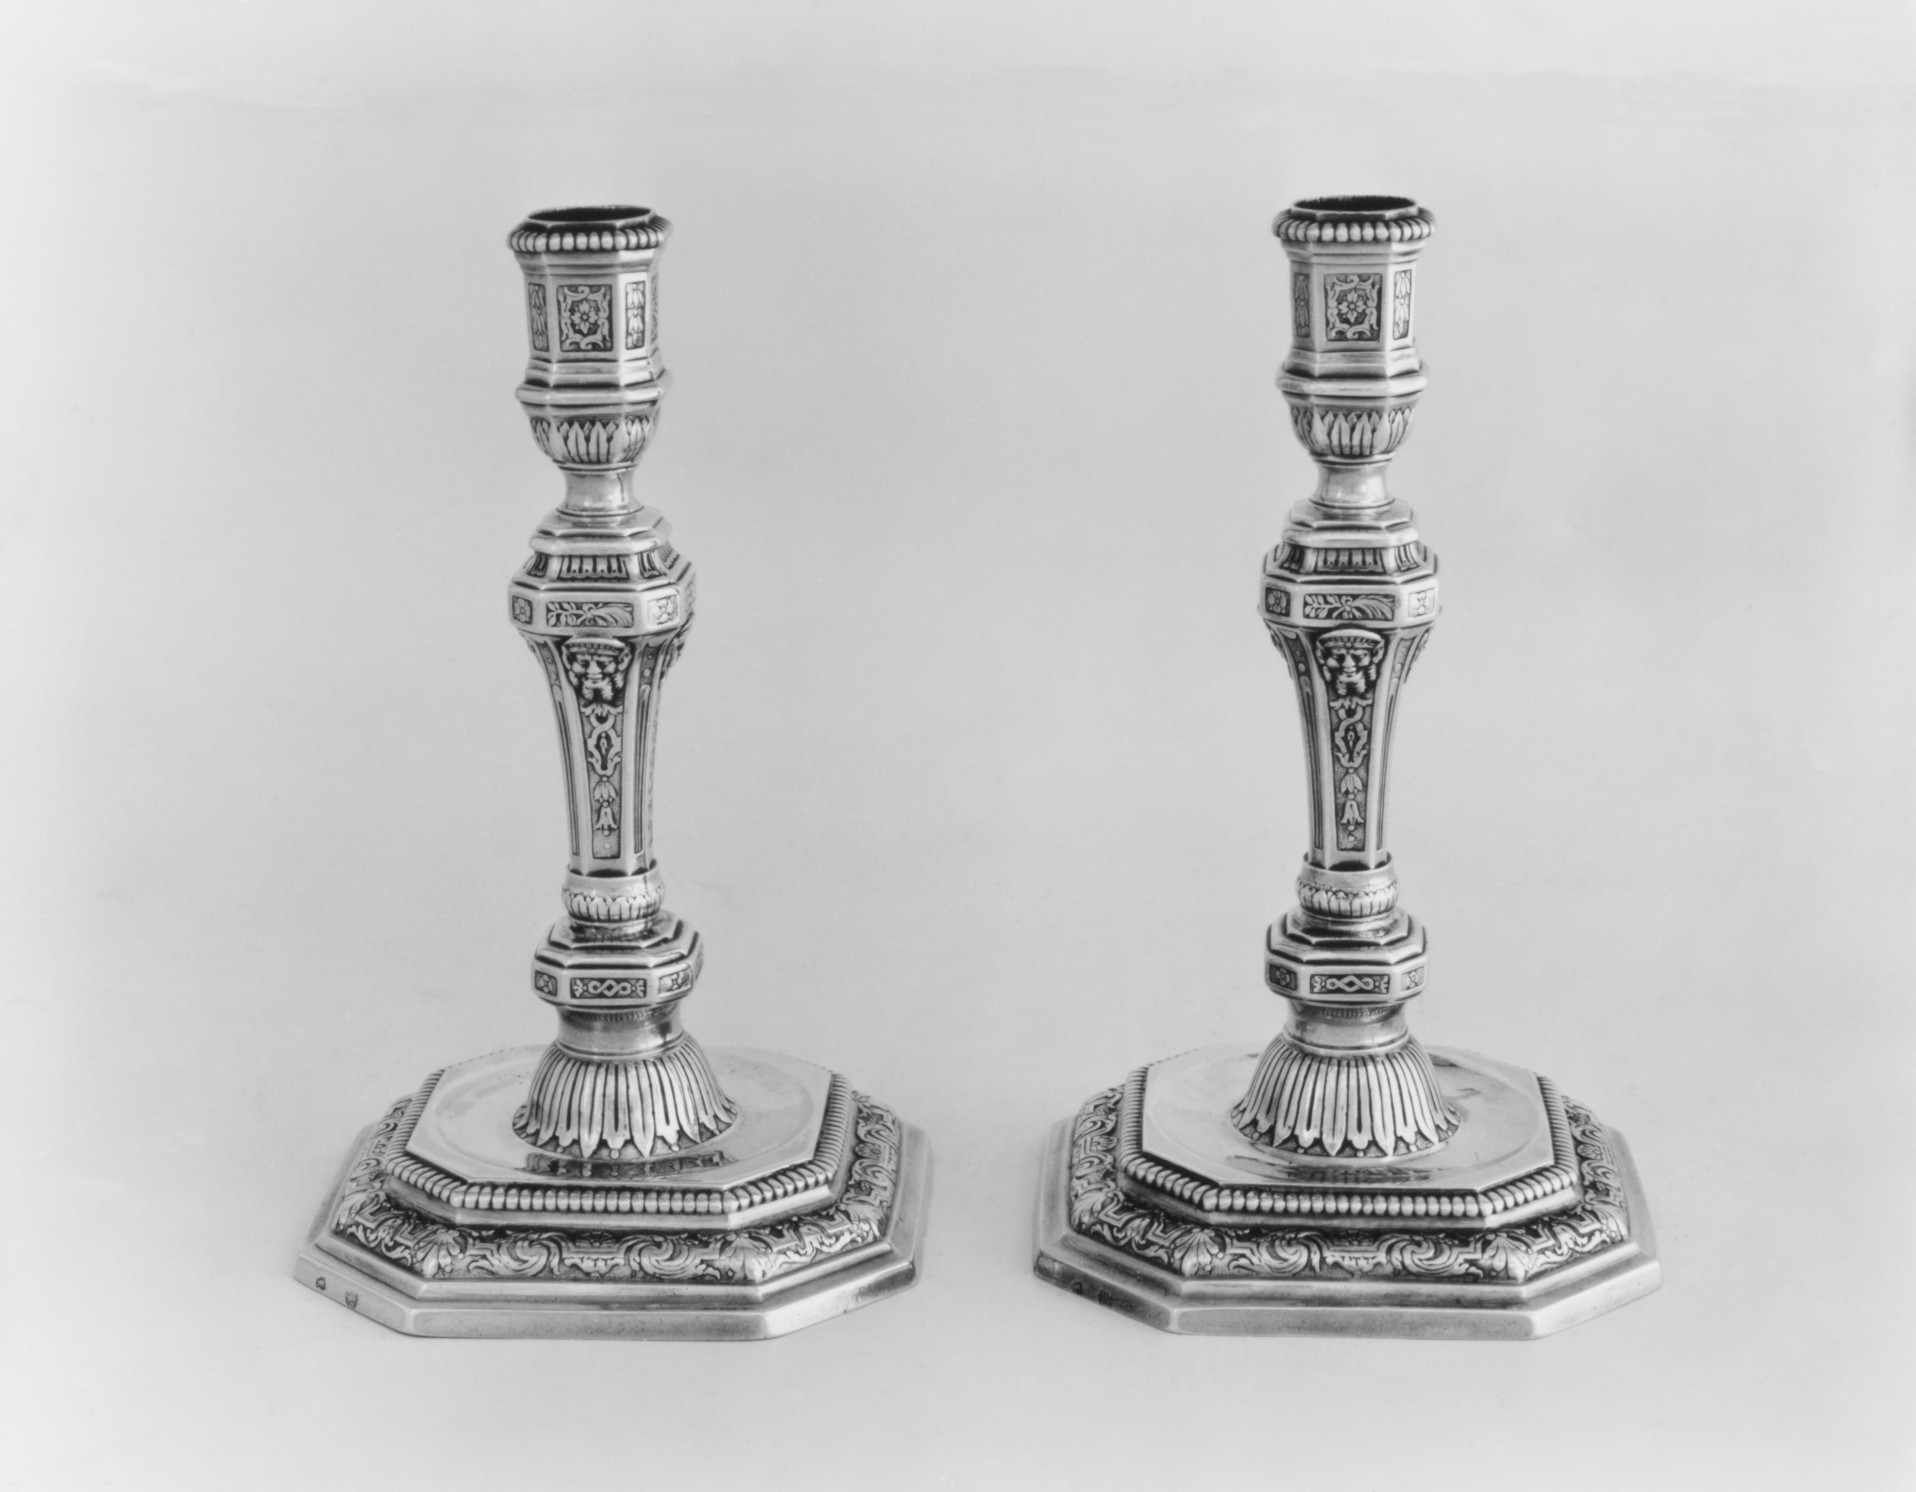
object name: candlestick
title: Pair of candlesticks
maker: louis dupérier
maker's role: maker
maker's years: 1642-1742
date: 1706-1707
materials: silver